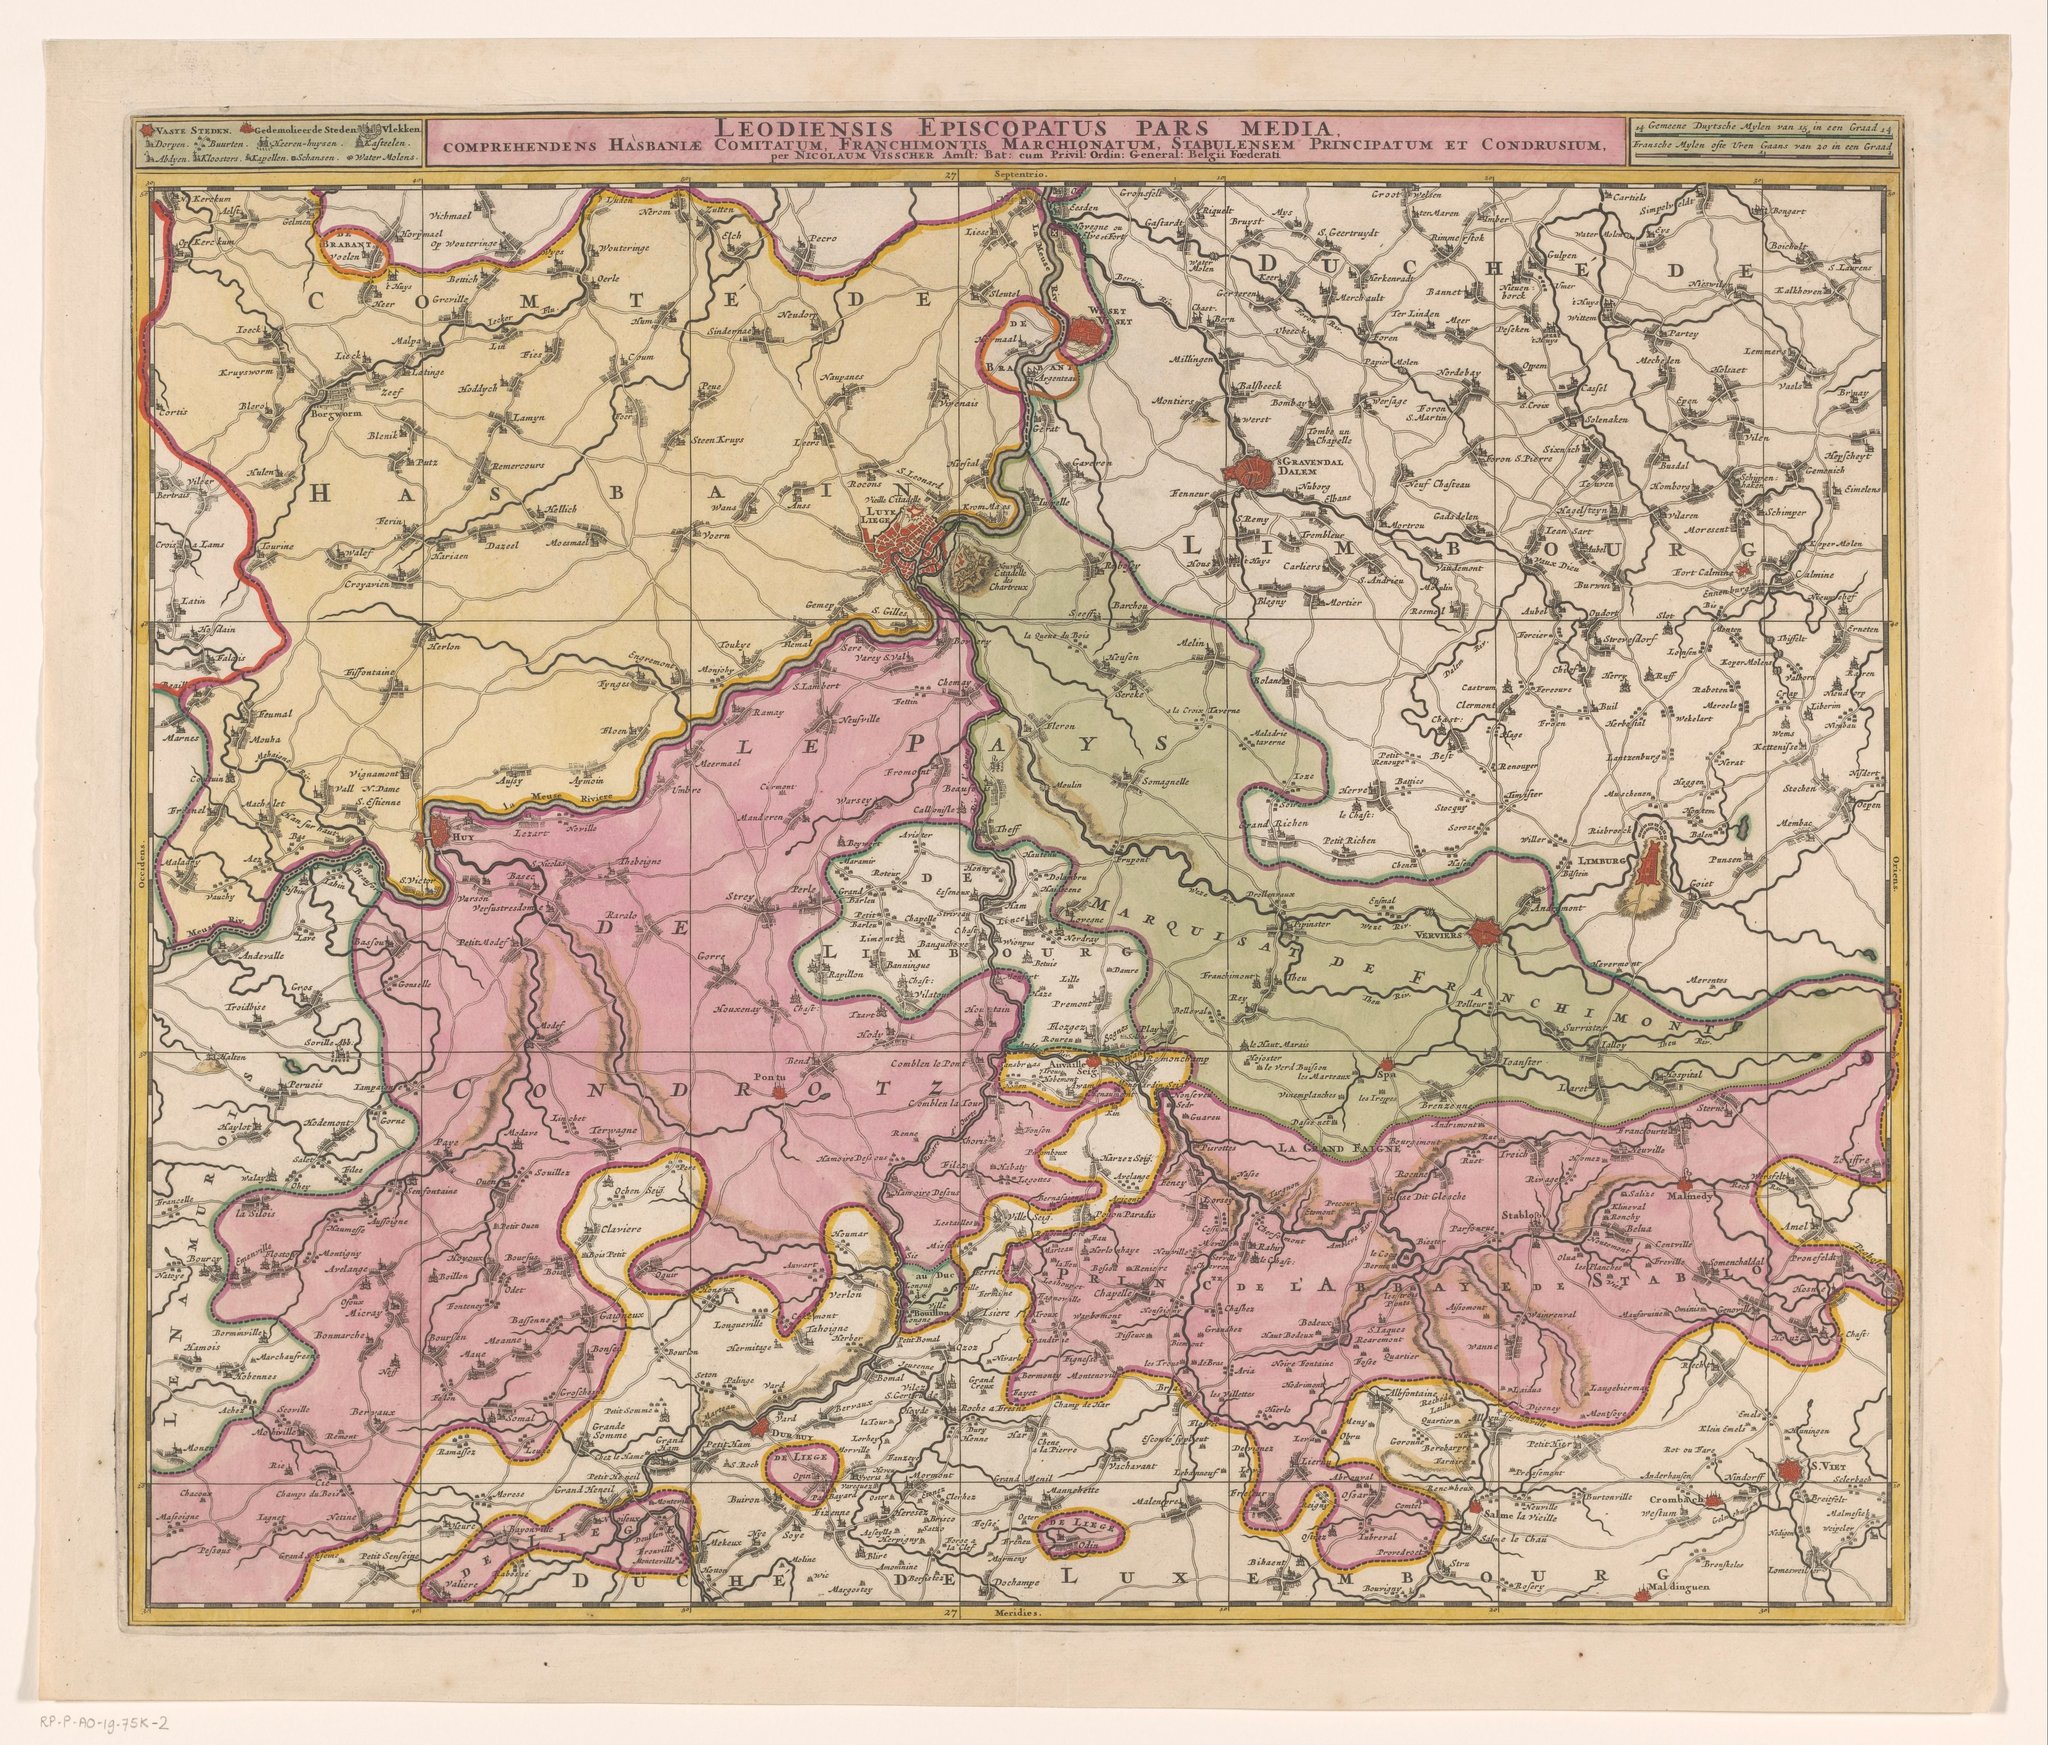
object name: map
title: Leodiensis episcopatus pars media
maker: Anonymous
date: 1677-1720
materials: paper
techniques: engraving, etching, hand coloring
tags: maps of separate countries or regions, prince-bishopric of liège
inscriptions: collector's mark: Lugt 2228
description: Kaart van het midden van het prinsbisdom Luik. In een balk boven de kaart, in het midden, de titel. Links hiervan een legenda. Rechts van de titel twee schaalstokken: 1 1/2 Gemeene Duytsche Mijlen van 15 in een Graad / 2 Fransche Mylen ofte Uren Gaans van 20 in een Graad. De kaart is voorzien van een coördinaten-net en een gradenverdeling.